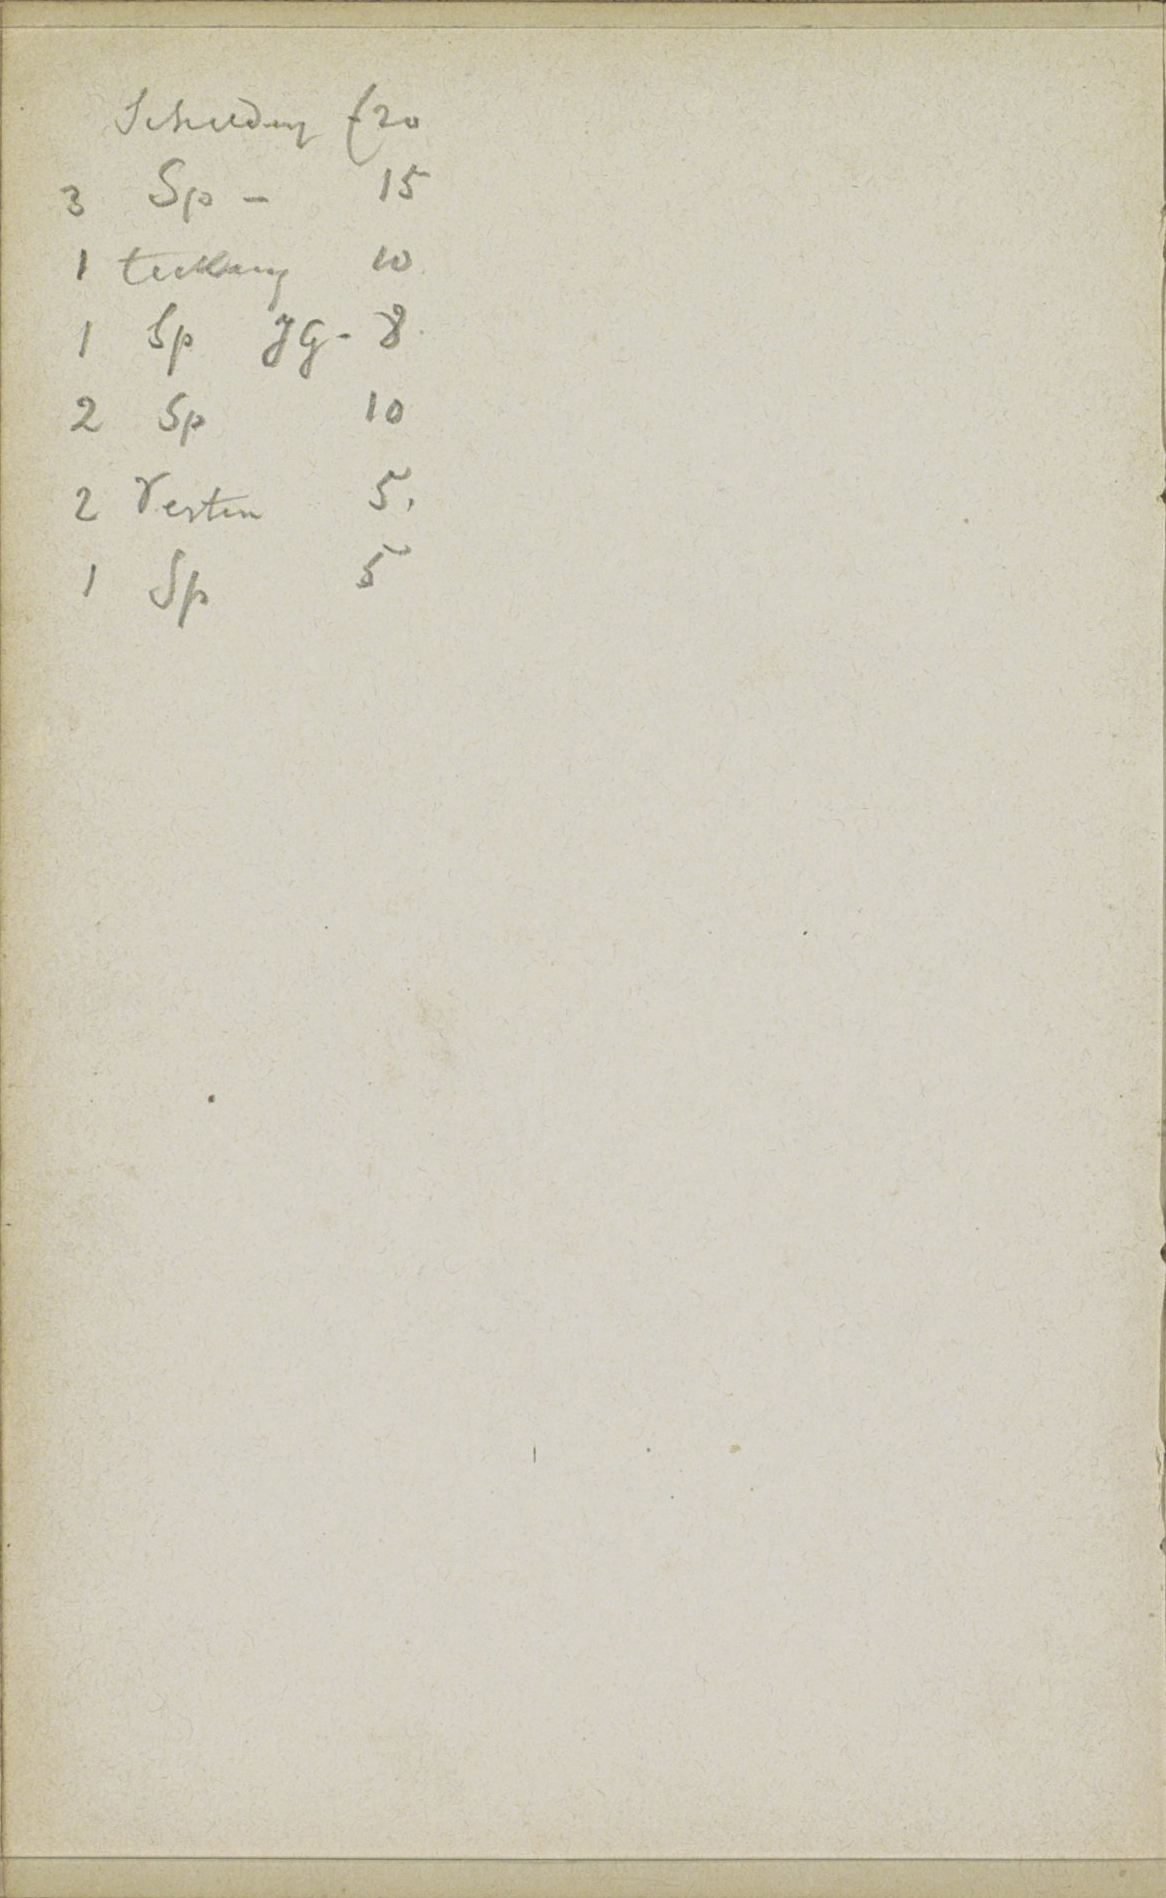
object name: sketchbook leaf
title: Annotaties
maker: adrianus eversen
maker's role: draughtsman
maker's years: 1818-1897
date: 1828-1897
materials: paper, pencil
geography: netherlands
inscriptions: annotation: ‘Schildery f20/ 3 Sp - 15/ 1 teekening 10/ 1 Sp JG-8/ 2 Sp 10/ 2 Vert[...] 5/ 1 Sp 5’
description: Aantekeningen over prijzen van werken. Blad 2 verso uit een schetsboek met 69 bladen vervaardigd in de omgeving van Delft, Rotterdam, Oudewater en Harlingen.